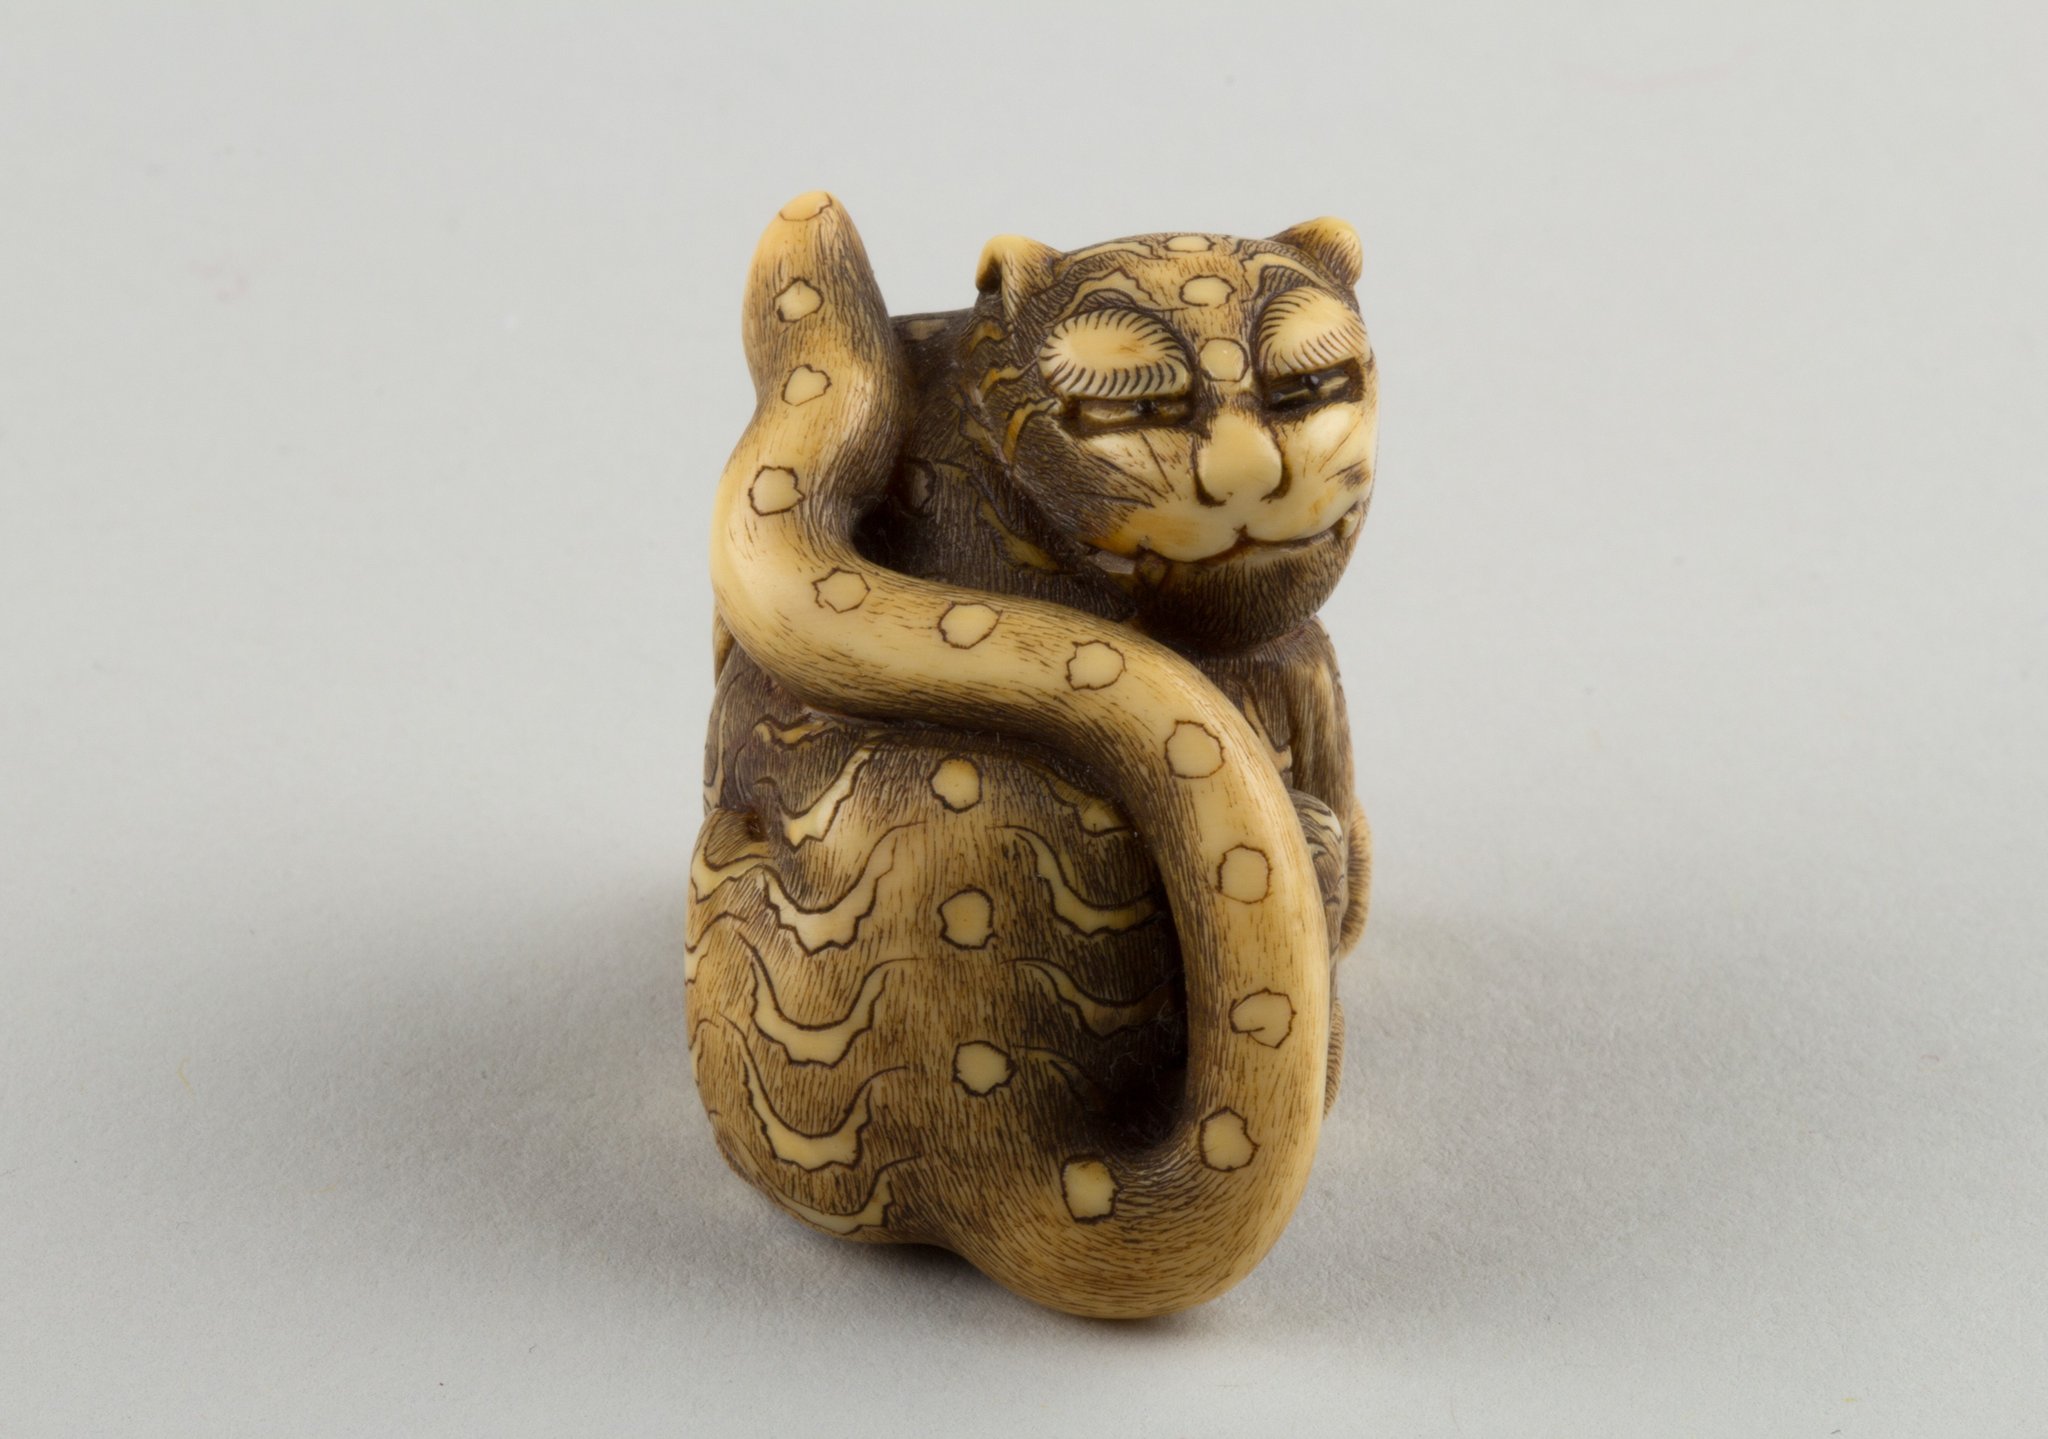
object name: netsuke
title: Netsuke of Seated Tiger with a Curled-up Tail Across its Back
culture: japanese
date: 1767-1833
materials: horn, ivory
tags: tigers